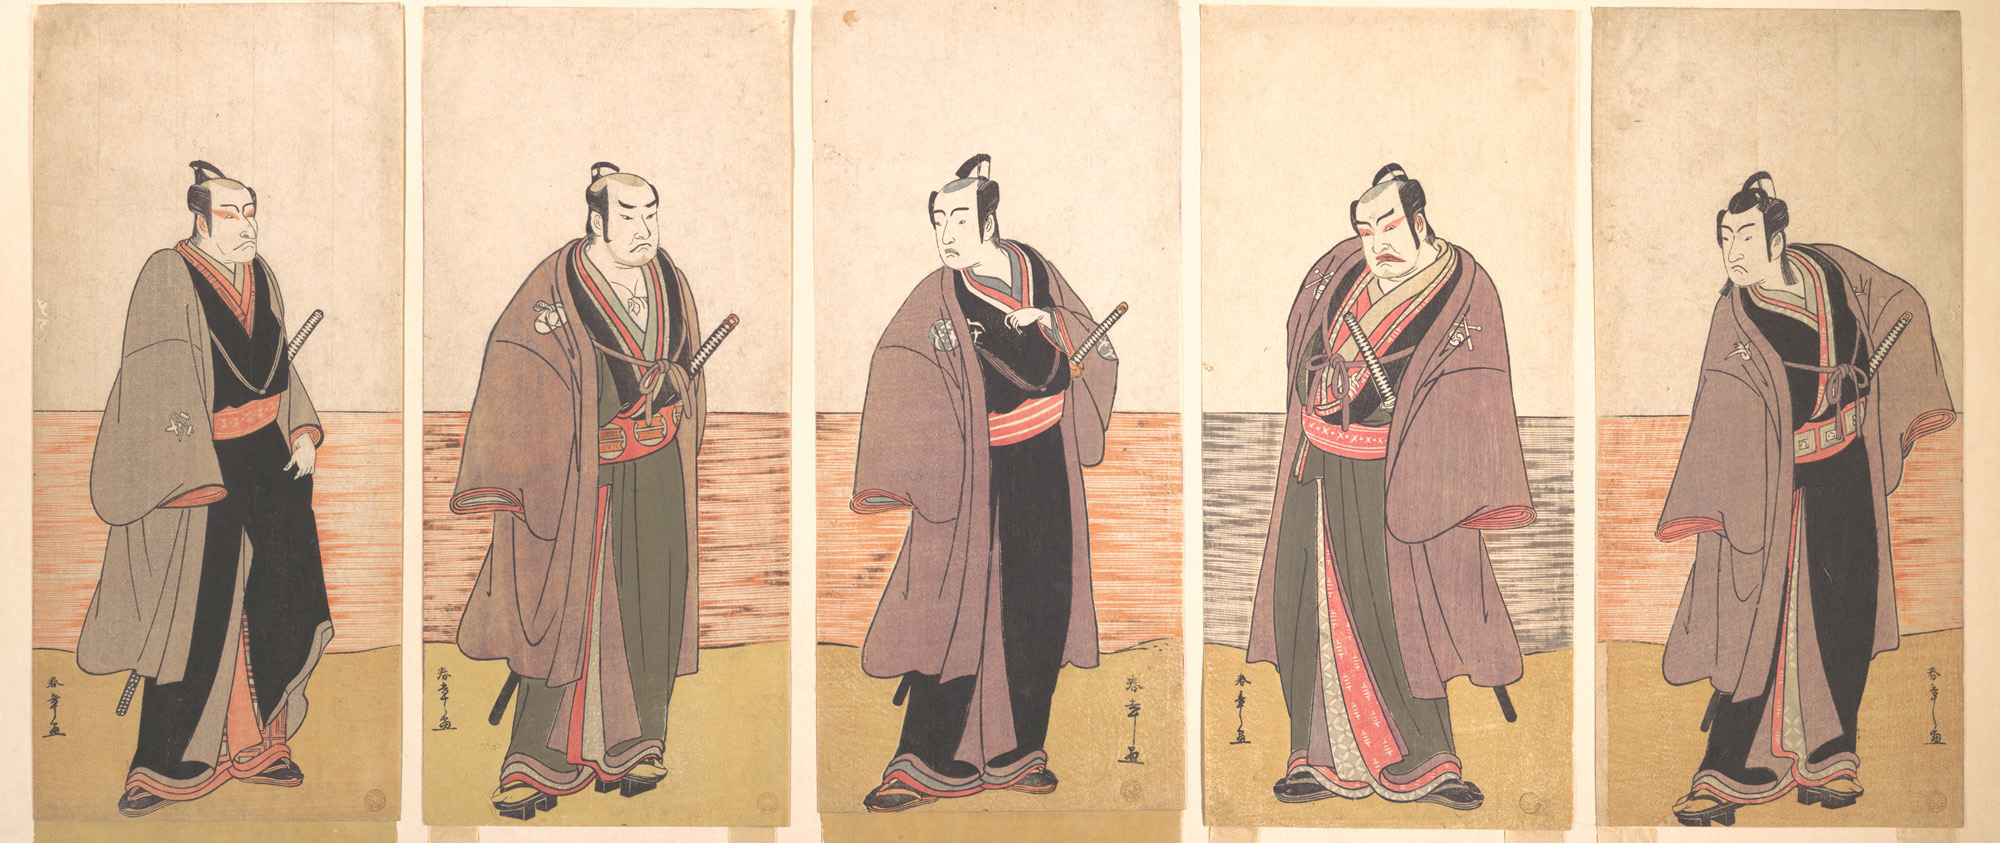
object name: woodblock print nishiki e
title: Ichikawa Danjuro V as a Chivalrous Commoner (Gonin Otoko) from the Play "Hatsumonbi kuruwa Soga"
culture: japanese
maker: katsukawa shunshō 勝川春章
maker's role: artist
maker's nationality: japanese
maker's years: 1726-1792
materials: ink, paper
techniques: nishiki e, woodblock print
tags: men,actors